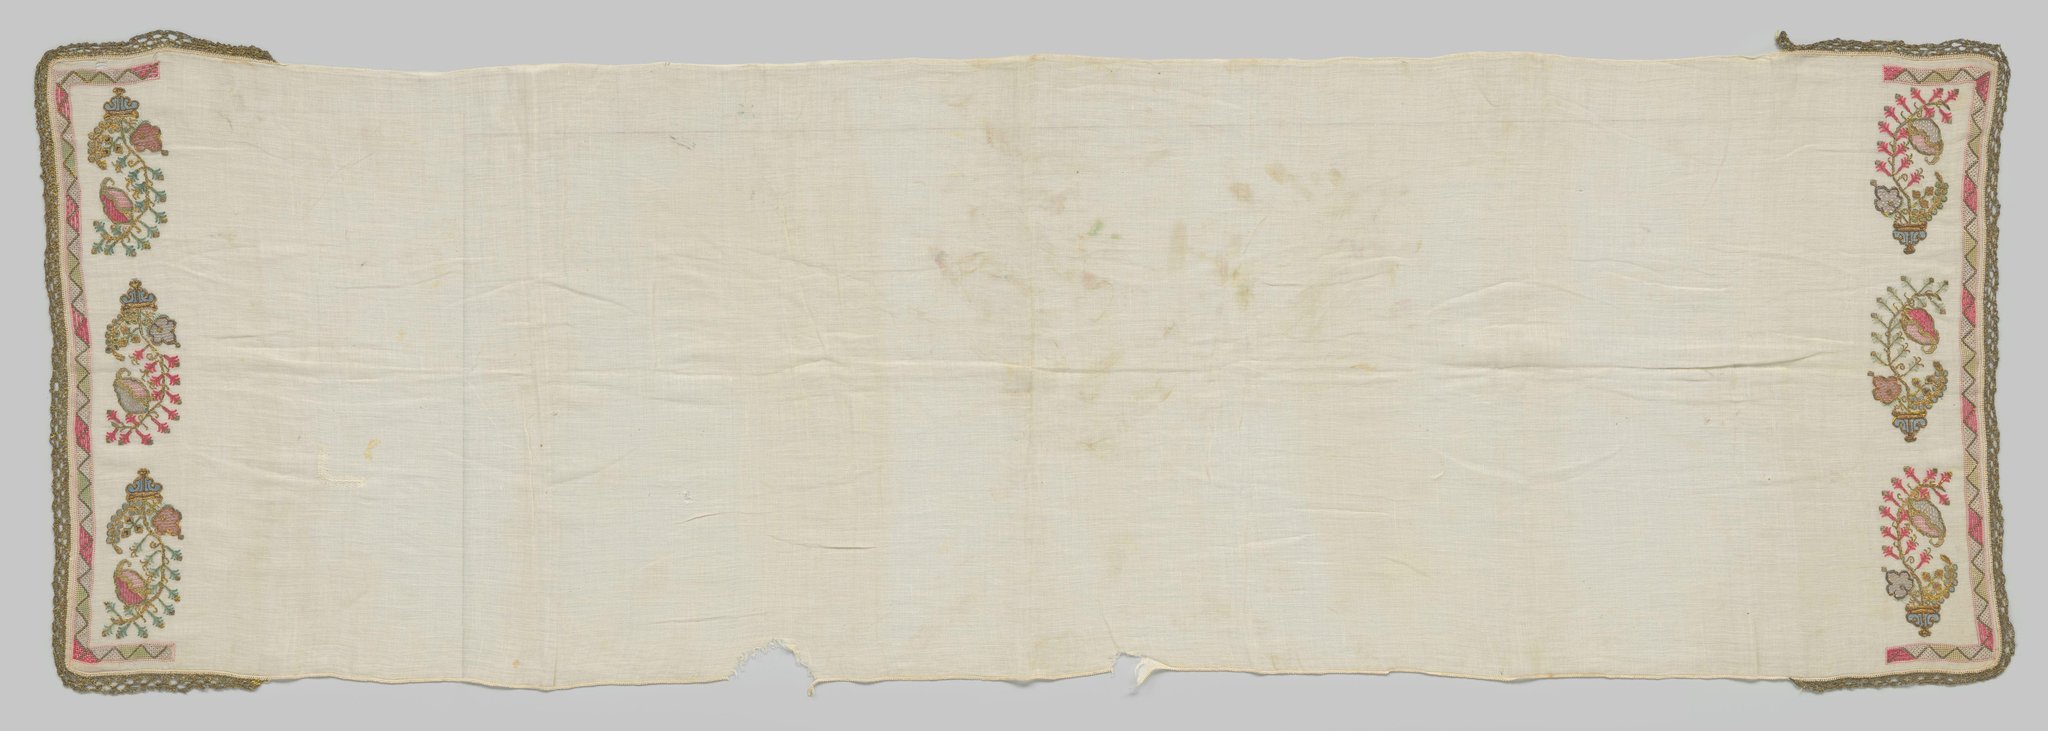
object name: clothing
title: Langwerpige sjaal van fijngeweven ecrukleurige katoen met aan beide uiteinden drie bonte borduursels met gouddraad en een smalle strook goudkant langs de rand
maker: Anonymous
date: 1800-1830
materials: cotton, gold thread, silk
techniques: embroidered, weave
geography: turkey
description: Langwerpige sjaal van fijngeweven ecrukleurige katoen met aan beide uiteinden drie bonte borduursels van (palm)takken in roze, blauw en grijsgroen met gouddraad. Langs de rand een baan waarbinnen een zigzagpatroon en aan de rand een smalle strook goudkant.